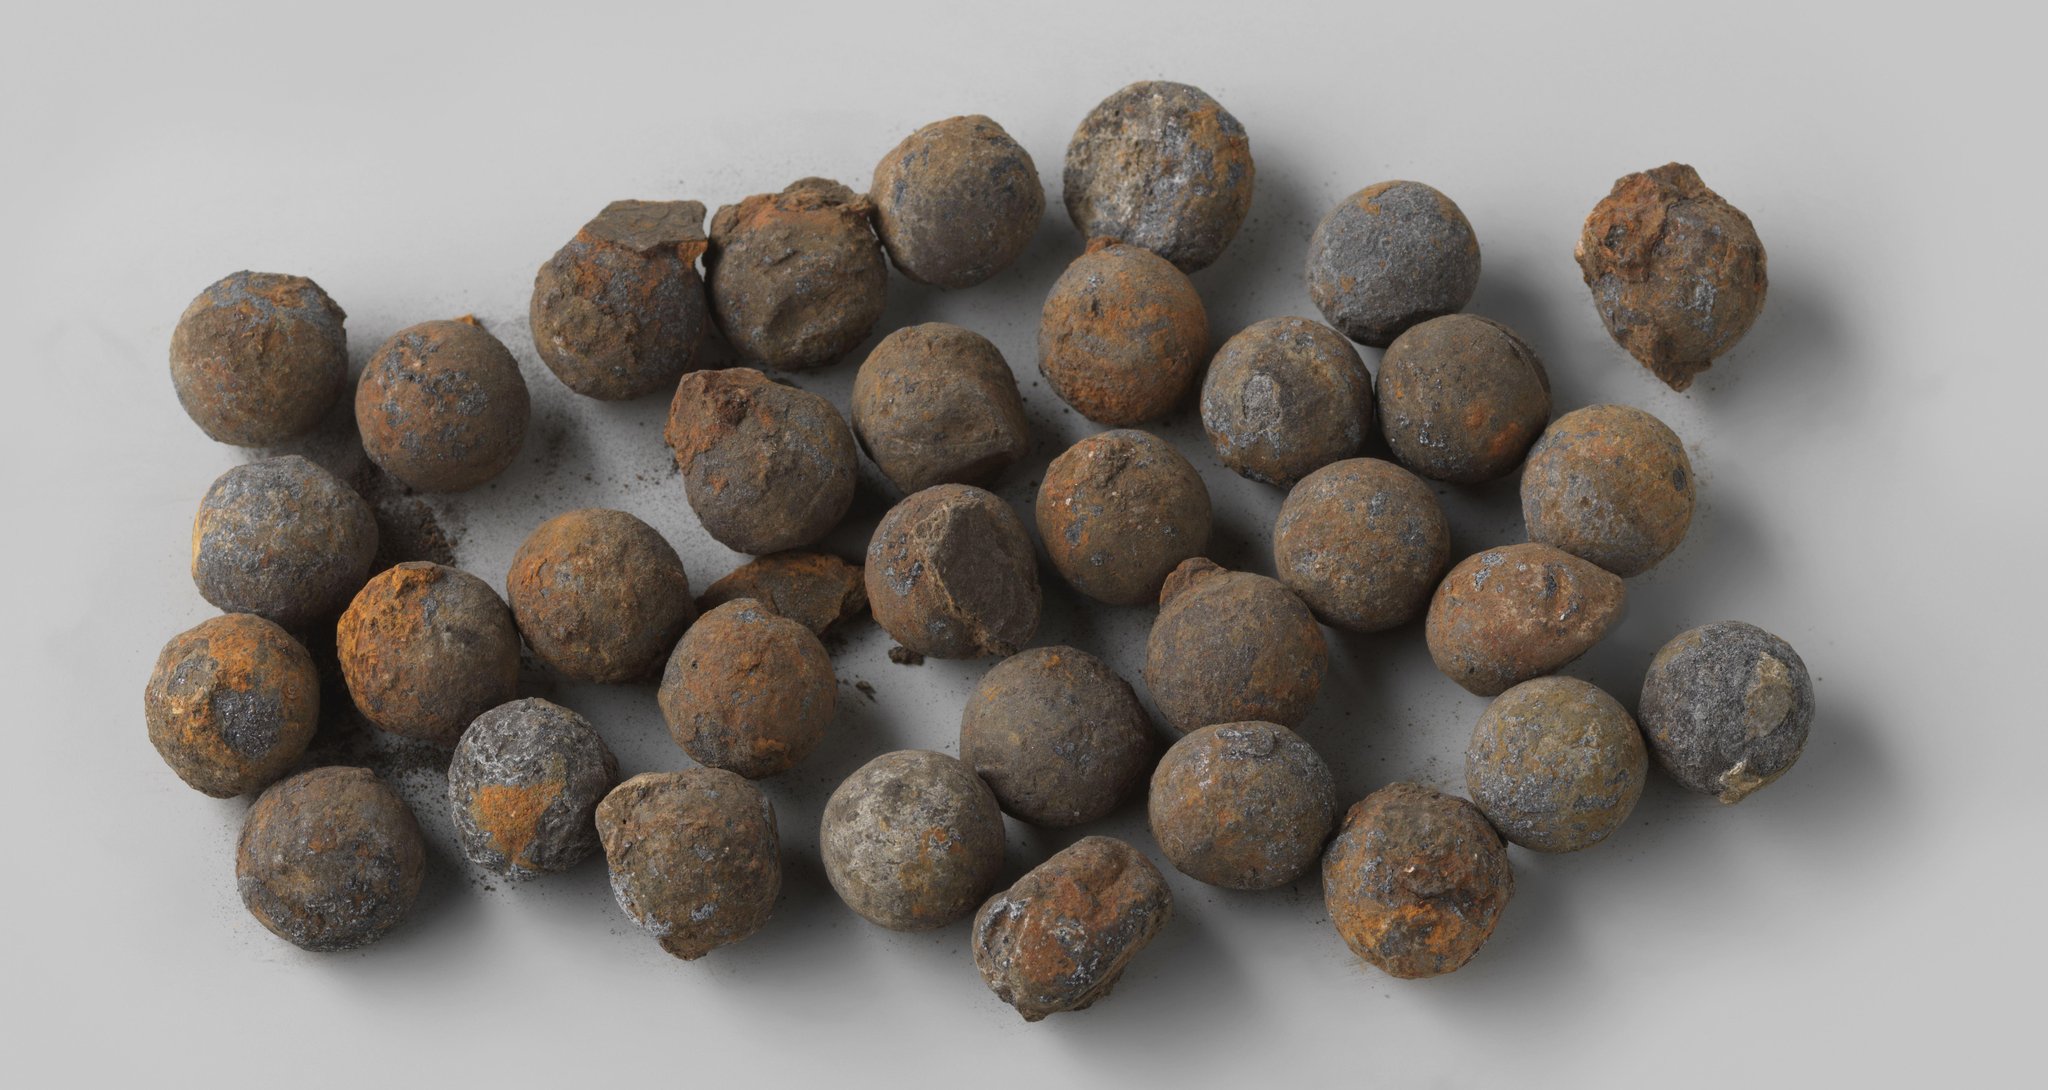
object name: musketkogel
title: Musketkogels uit het wrak van de Oost-Indiëvaarder Meresteijn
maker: Anonymous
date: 1693-1702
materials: lead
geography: northern netherlands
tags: cape of good hope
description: Vierendertig loden musketkogels, deels met aankoekingen. Massieve bolvormige kogels. Shot, musket.